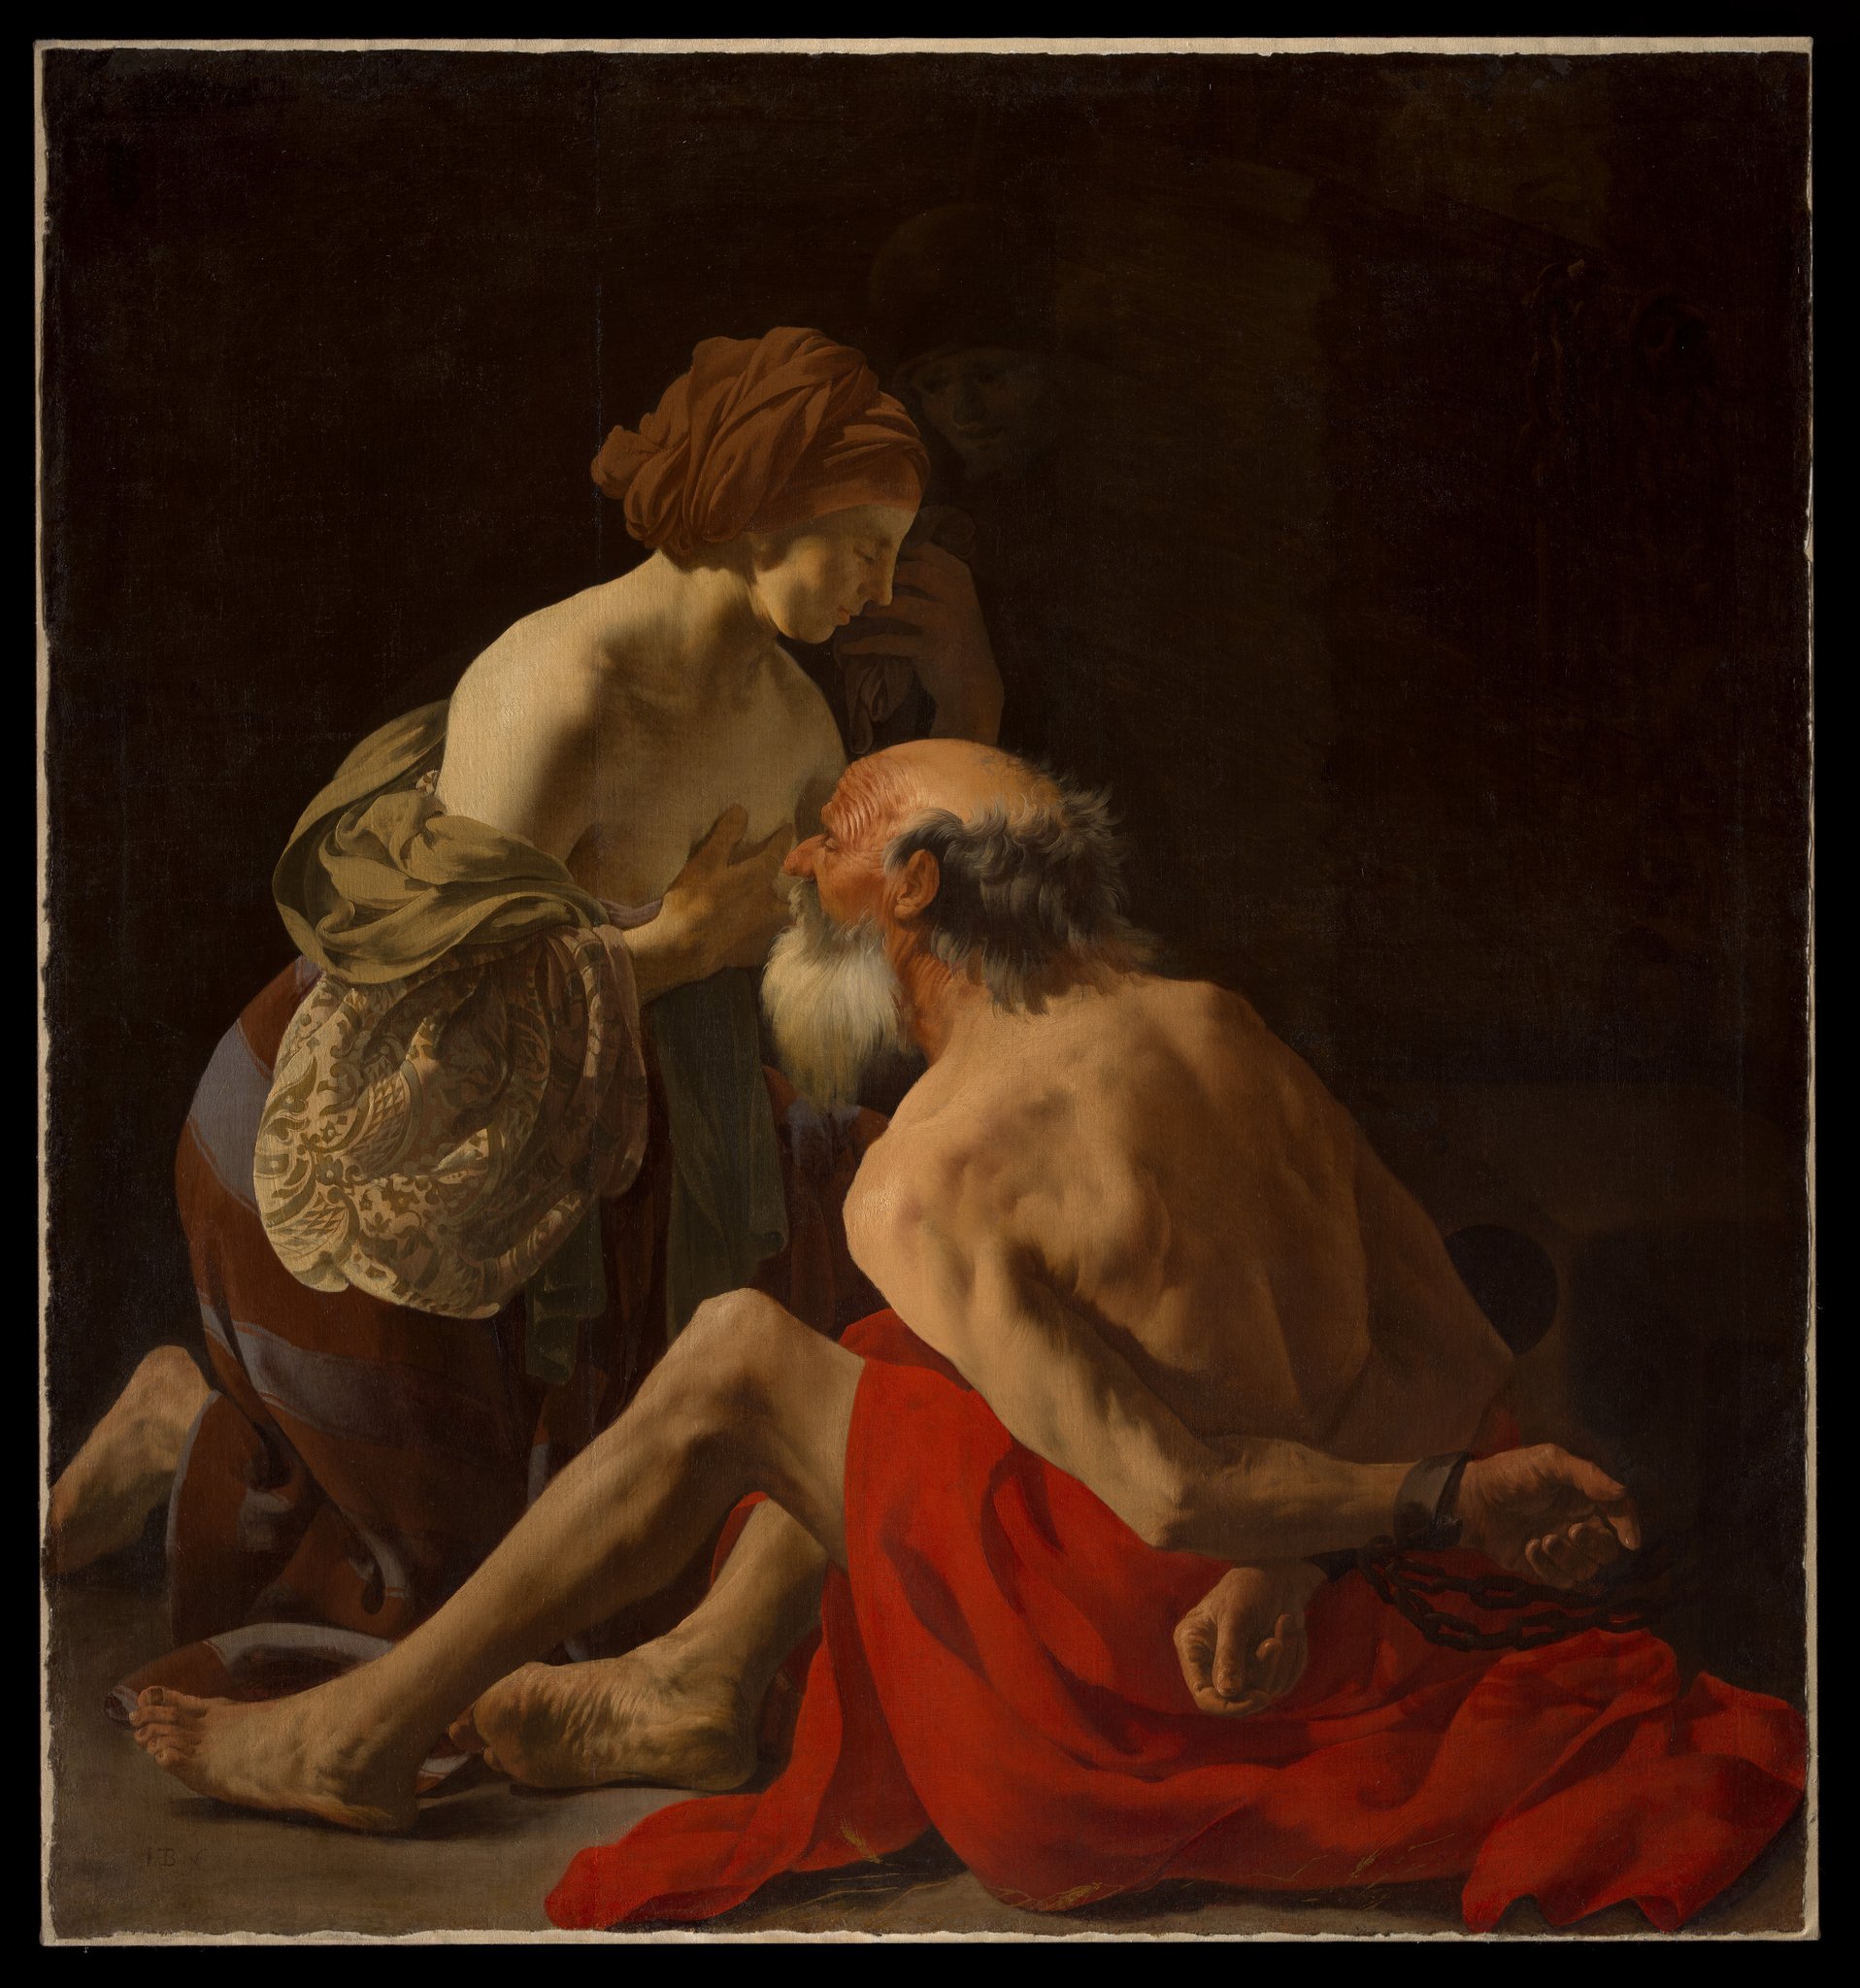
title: Roman Charity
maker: hendrick ter brugghen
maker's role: artist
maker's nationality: dutch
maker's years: 1588-1629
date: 1622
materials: canvas, oil